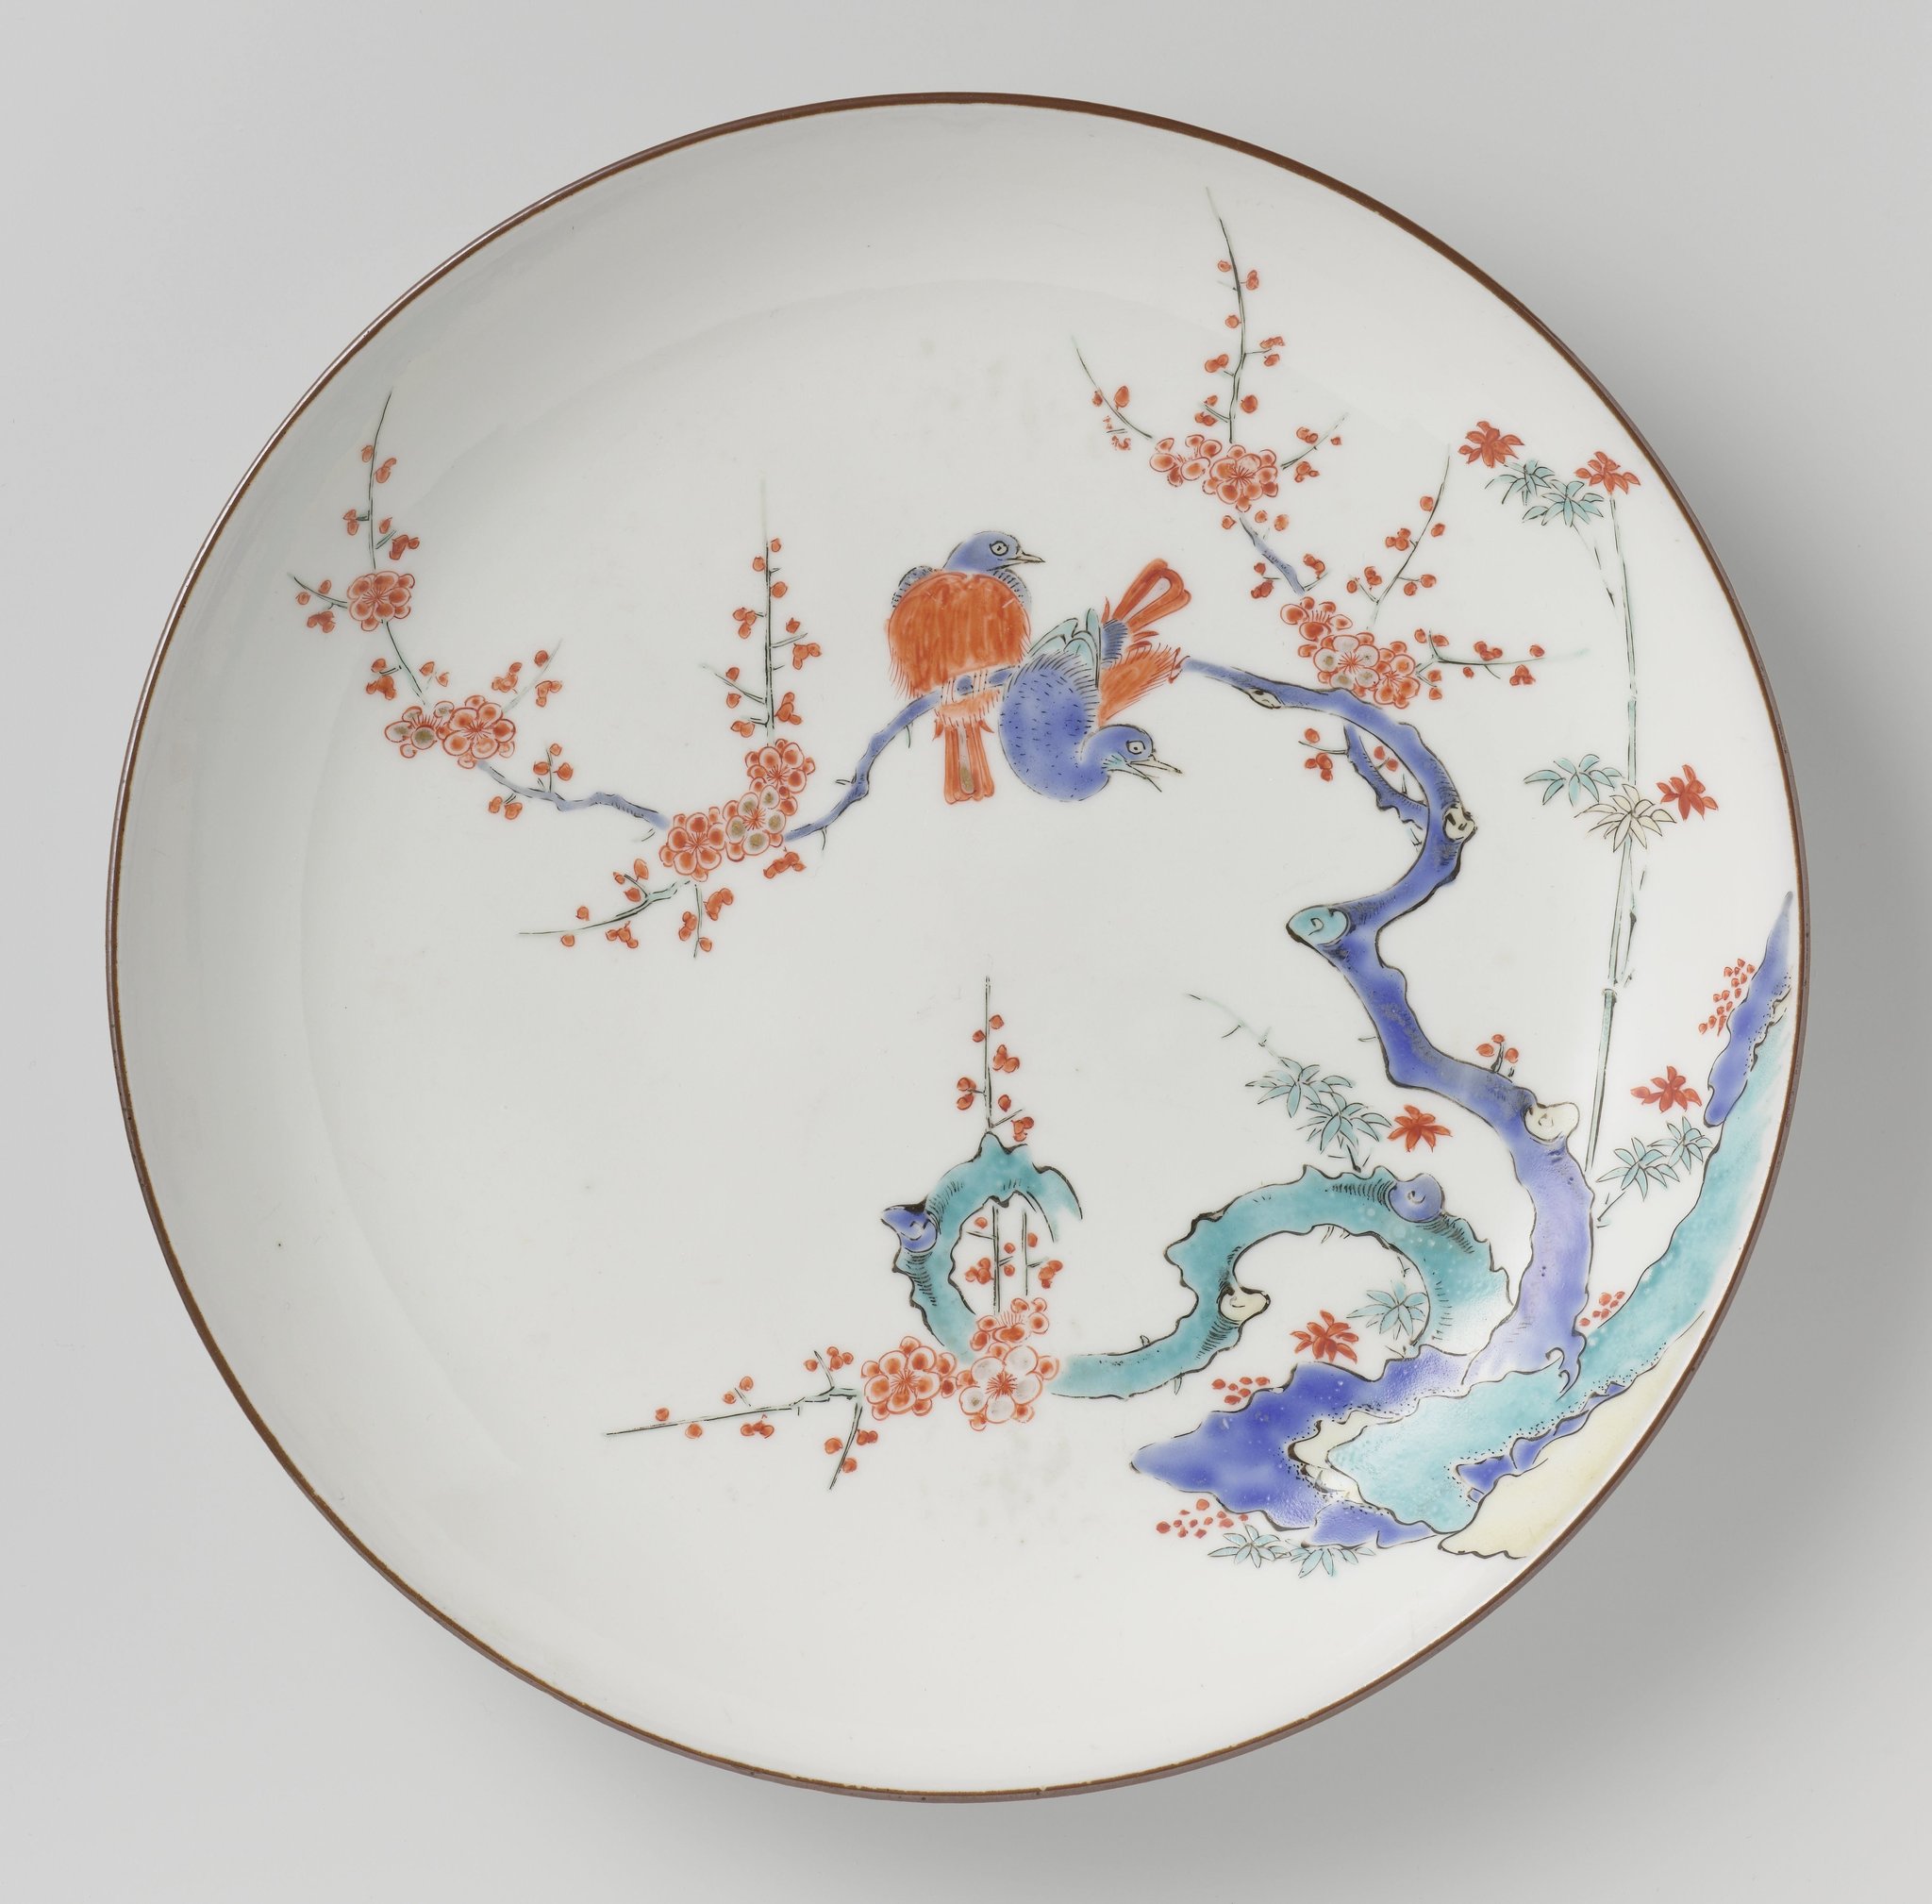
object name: plate dish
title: Dish with rocks, bamboo, prunus and birds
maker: Anonymous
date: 1670-1700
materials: glaze, gold, paint, porcelain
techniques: firing, gilding, turning, vitrification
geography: japan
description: Plate. Kakiemon. Japan, Arita, c. 1700. Porcelain, decoration in underglaze blue and enamels.